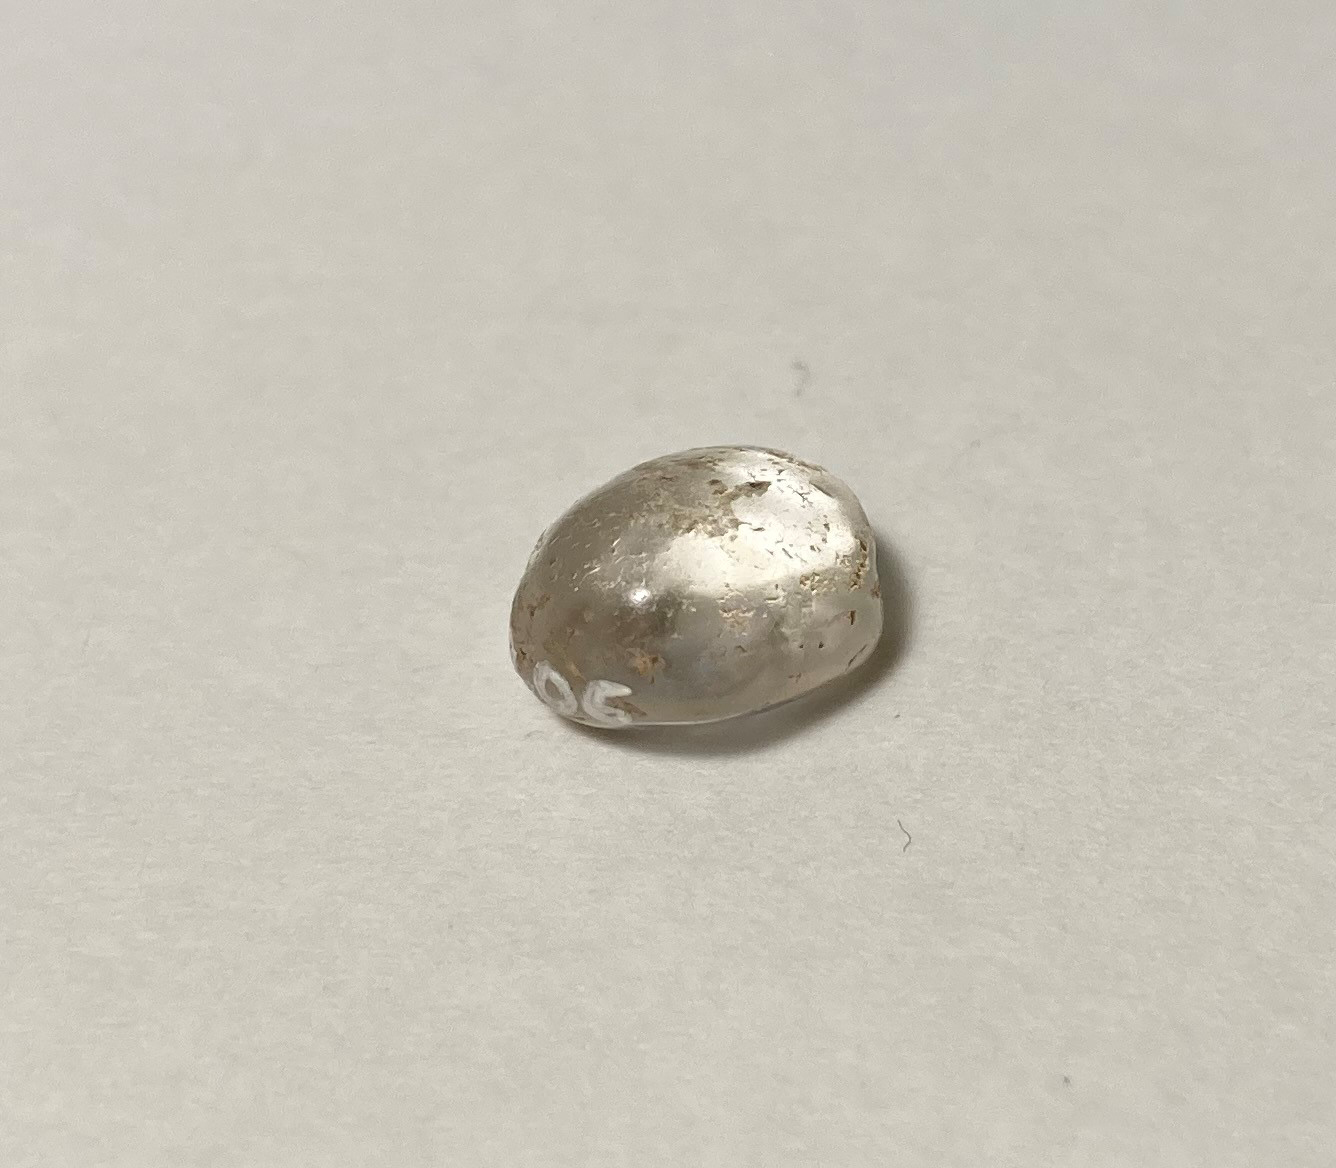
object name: bead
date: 701-1300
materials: quartz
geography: iran